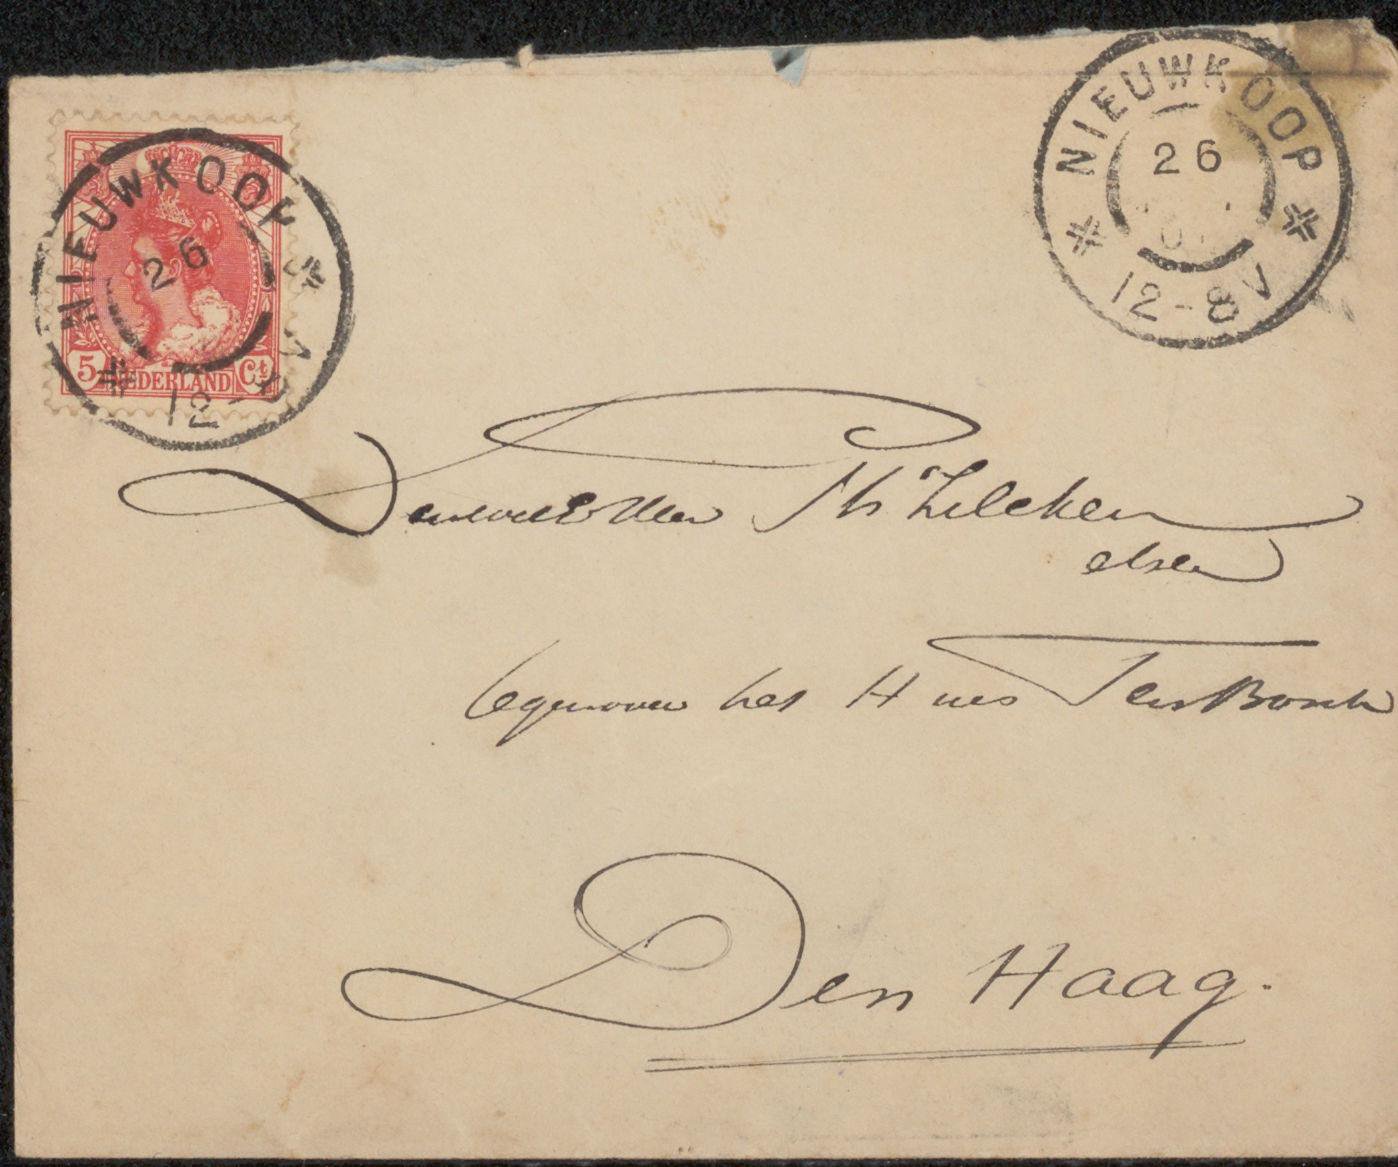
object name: envelope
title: Envelop aan Philip Zilcken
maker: waalko jans dingemans (i)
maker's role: draughtsman, print maker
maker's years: 1873-1925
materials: ink, paper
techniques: pen, writing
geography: nieuwkoop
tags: the hague, painter, philip zilcken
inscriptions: collector's mark: ‘RPK’